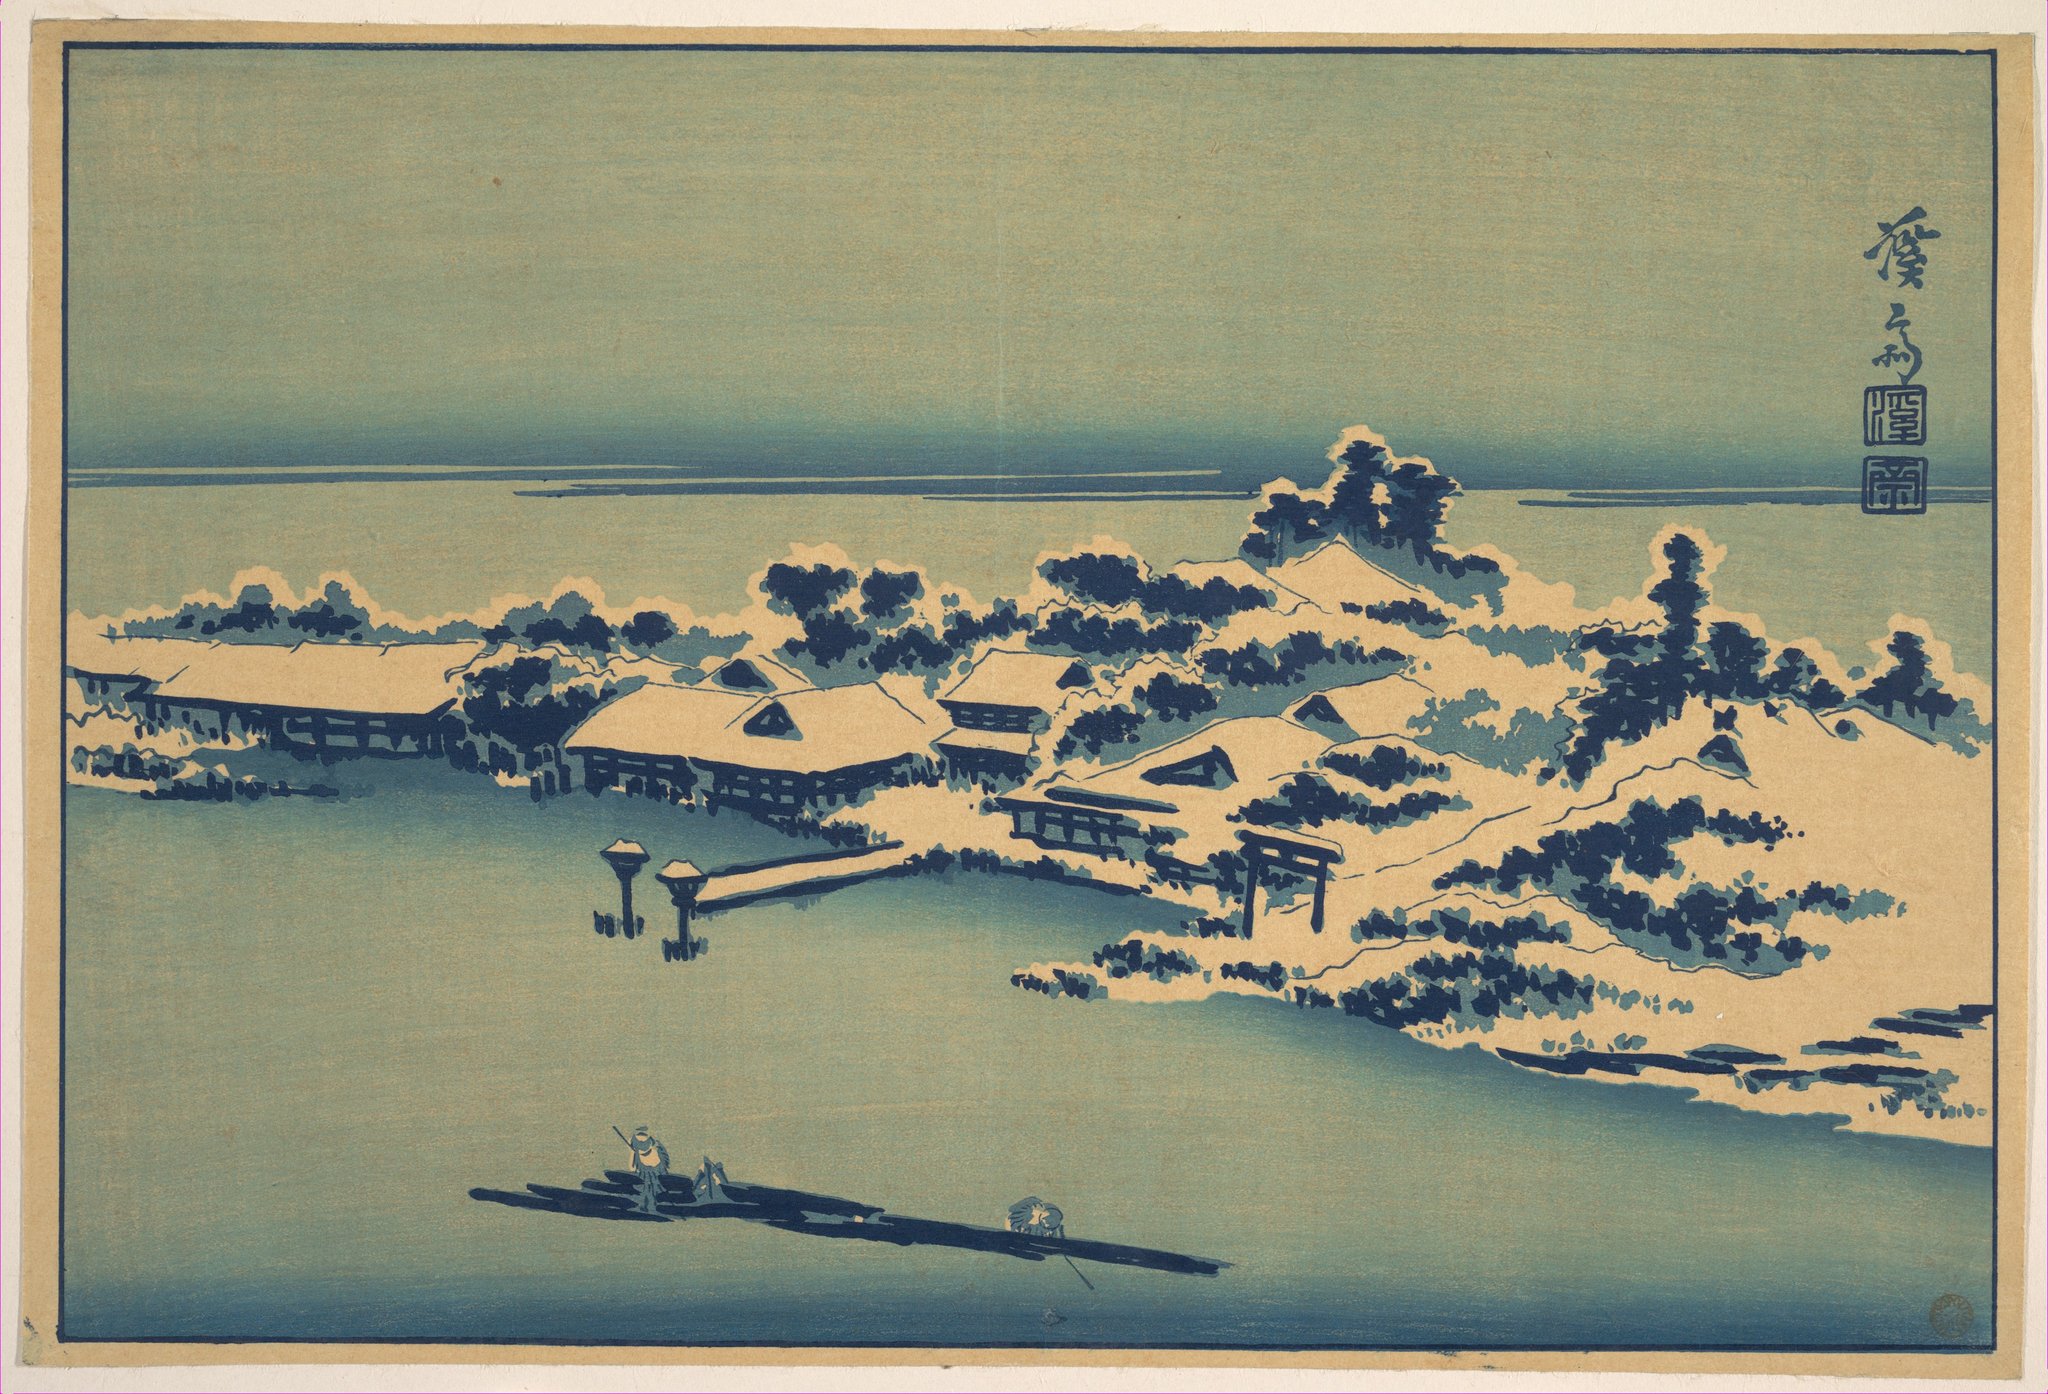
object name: print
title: Winter Landscape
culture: japanese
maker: keisai eisen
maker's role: artist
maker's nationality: japanese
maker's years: 1790-1848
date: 1790-1848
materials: ink, paper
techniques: woodblock print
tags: landscapes,winter,snow